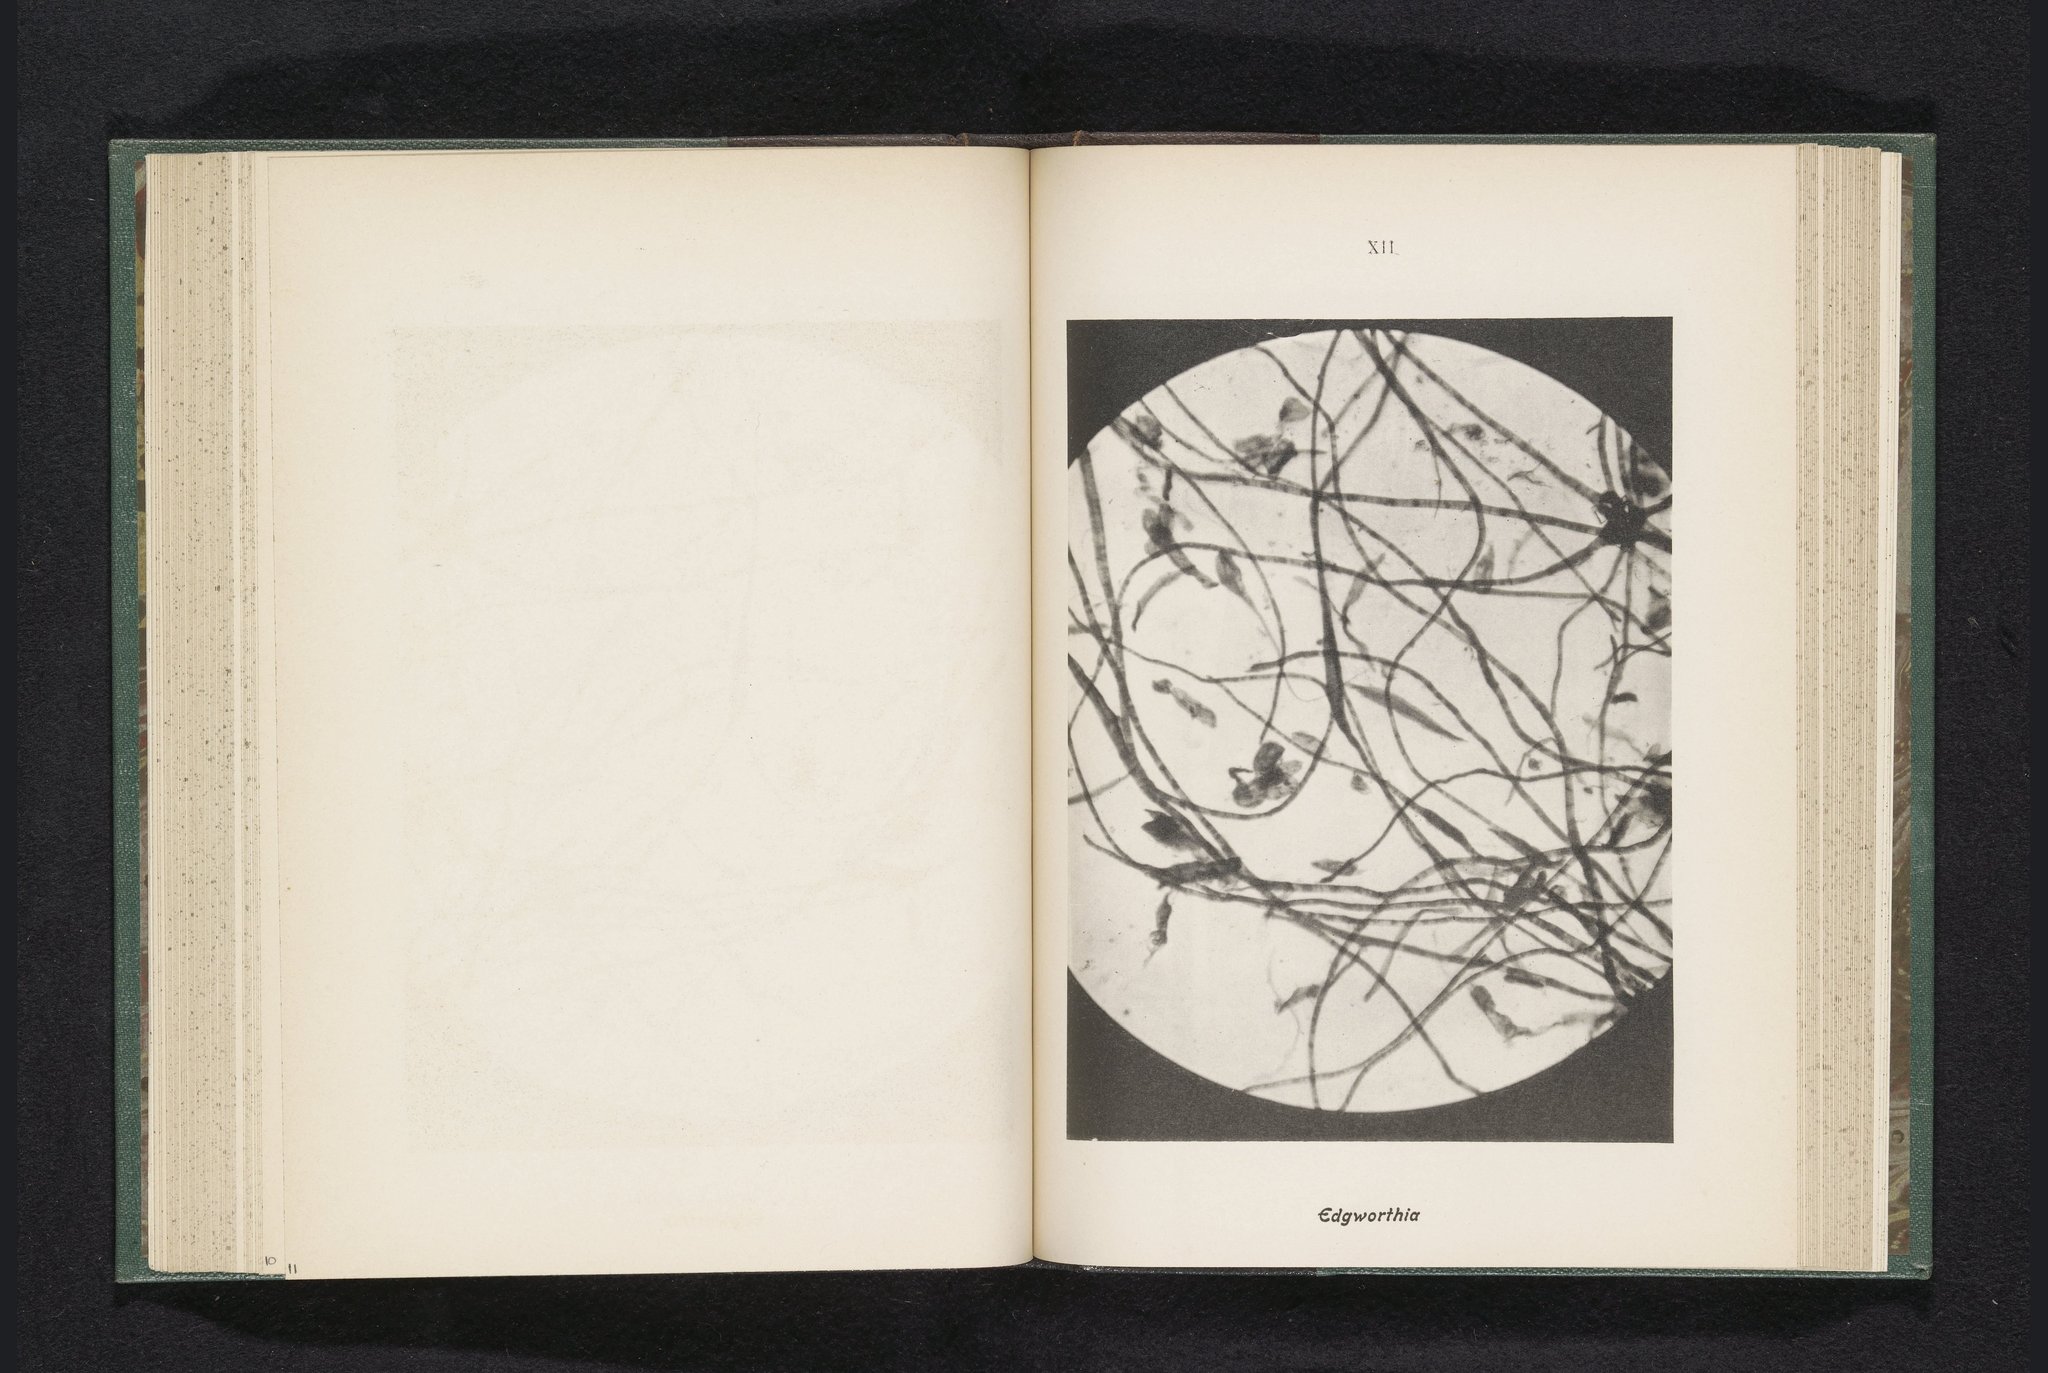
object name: page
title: Edgworthia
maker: Anonymous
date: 1890-1900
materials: paper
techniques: photograph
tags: microscope (+ scientific research)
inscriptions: number: ‘XII’